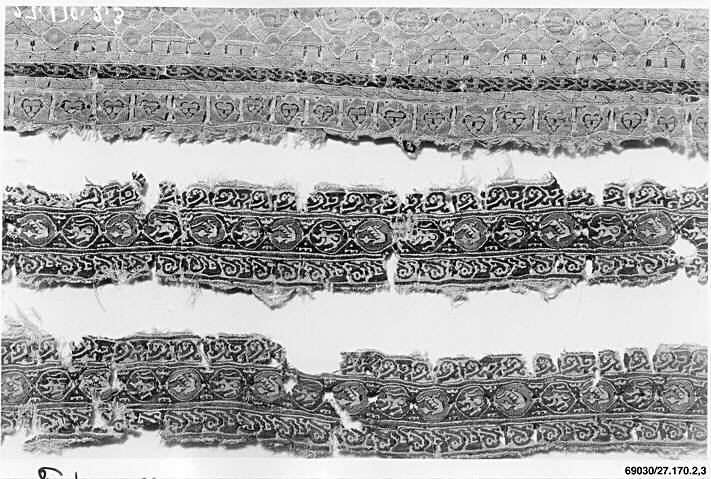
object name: band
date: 1101-1200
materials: linen, silk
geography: egypt